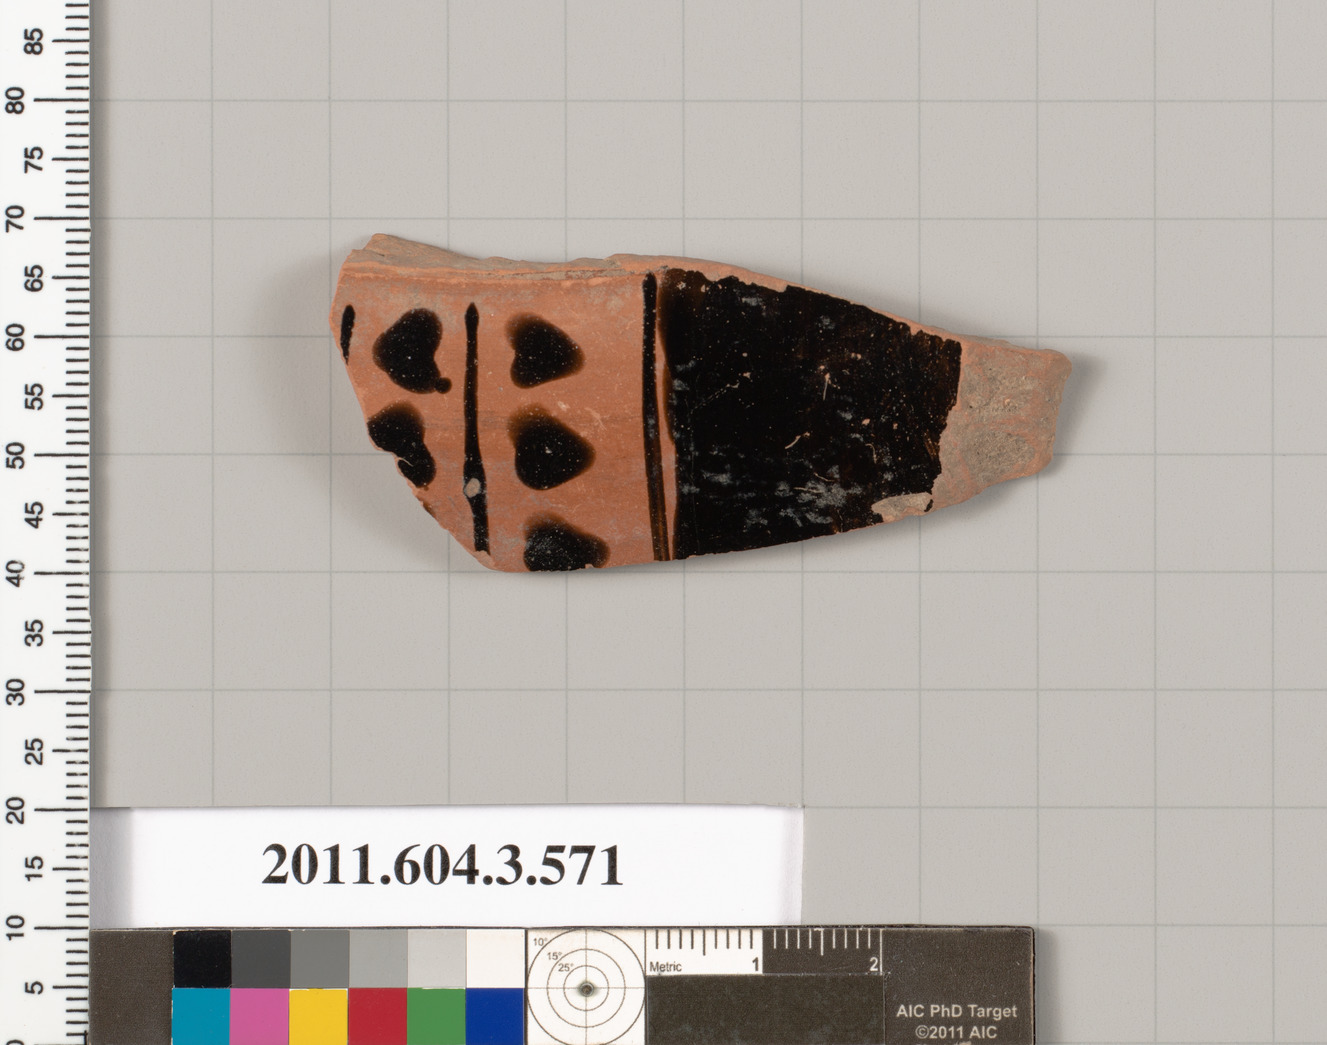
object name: column krater fragment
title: Terracotta fragment of a column-krater (bowl for mixing wine and water)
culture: greek, attic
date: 534-468 BCE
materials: terracotta